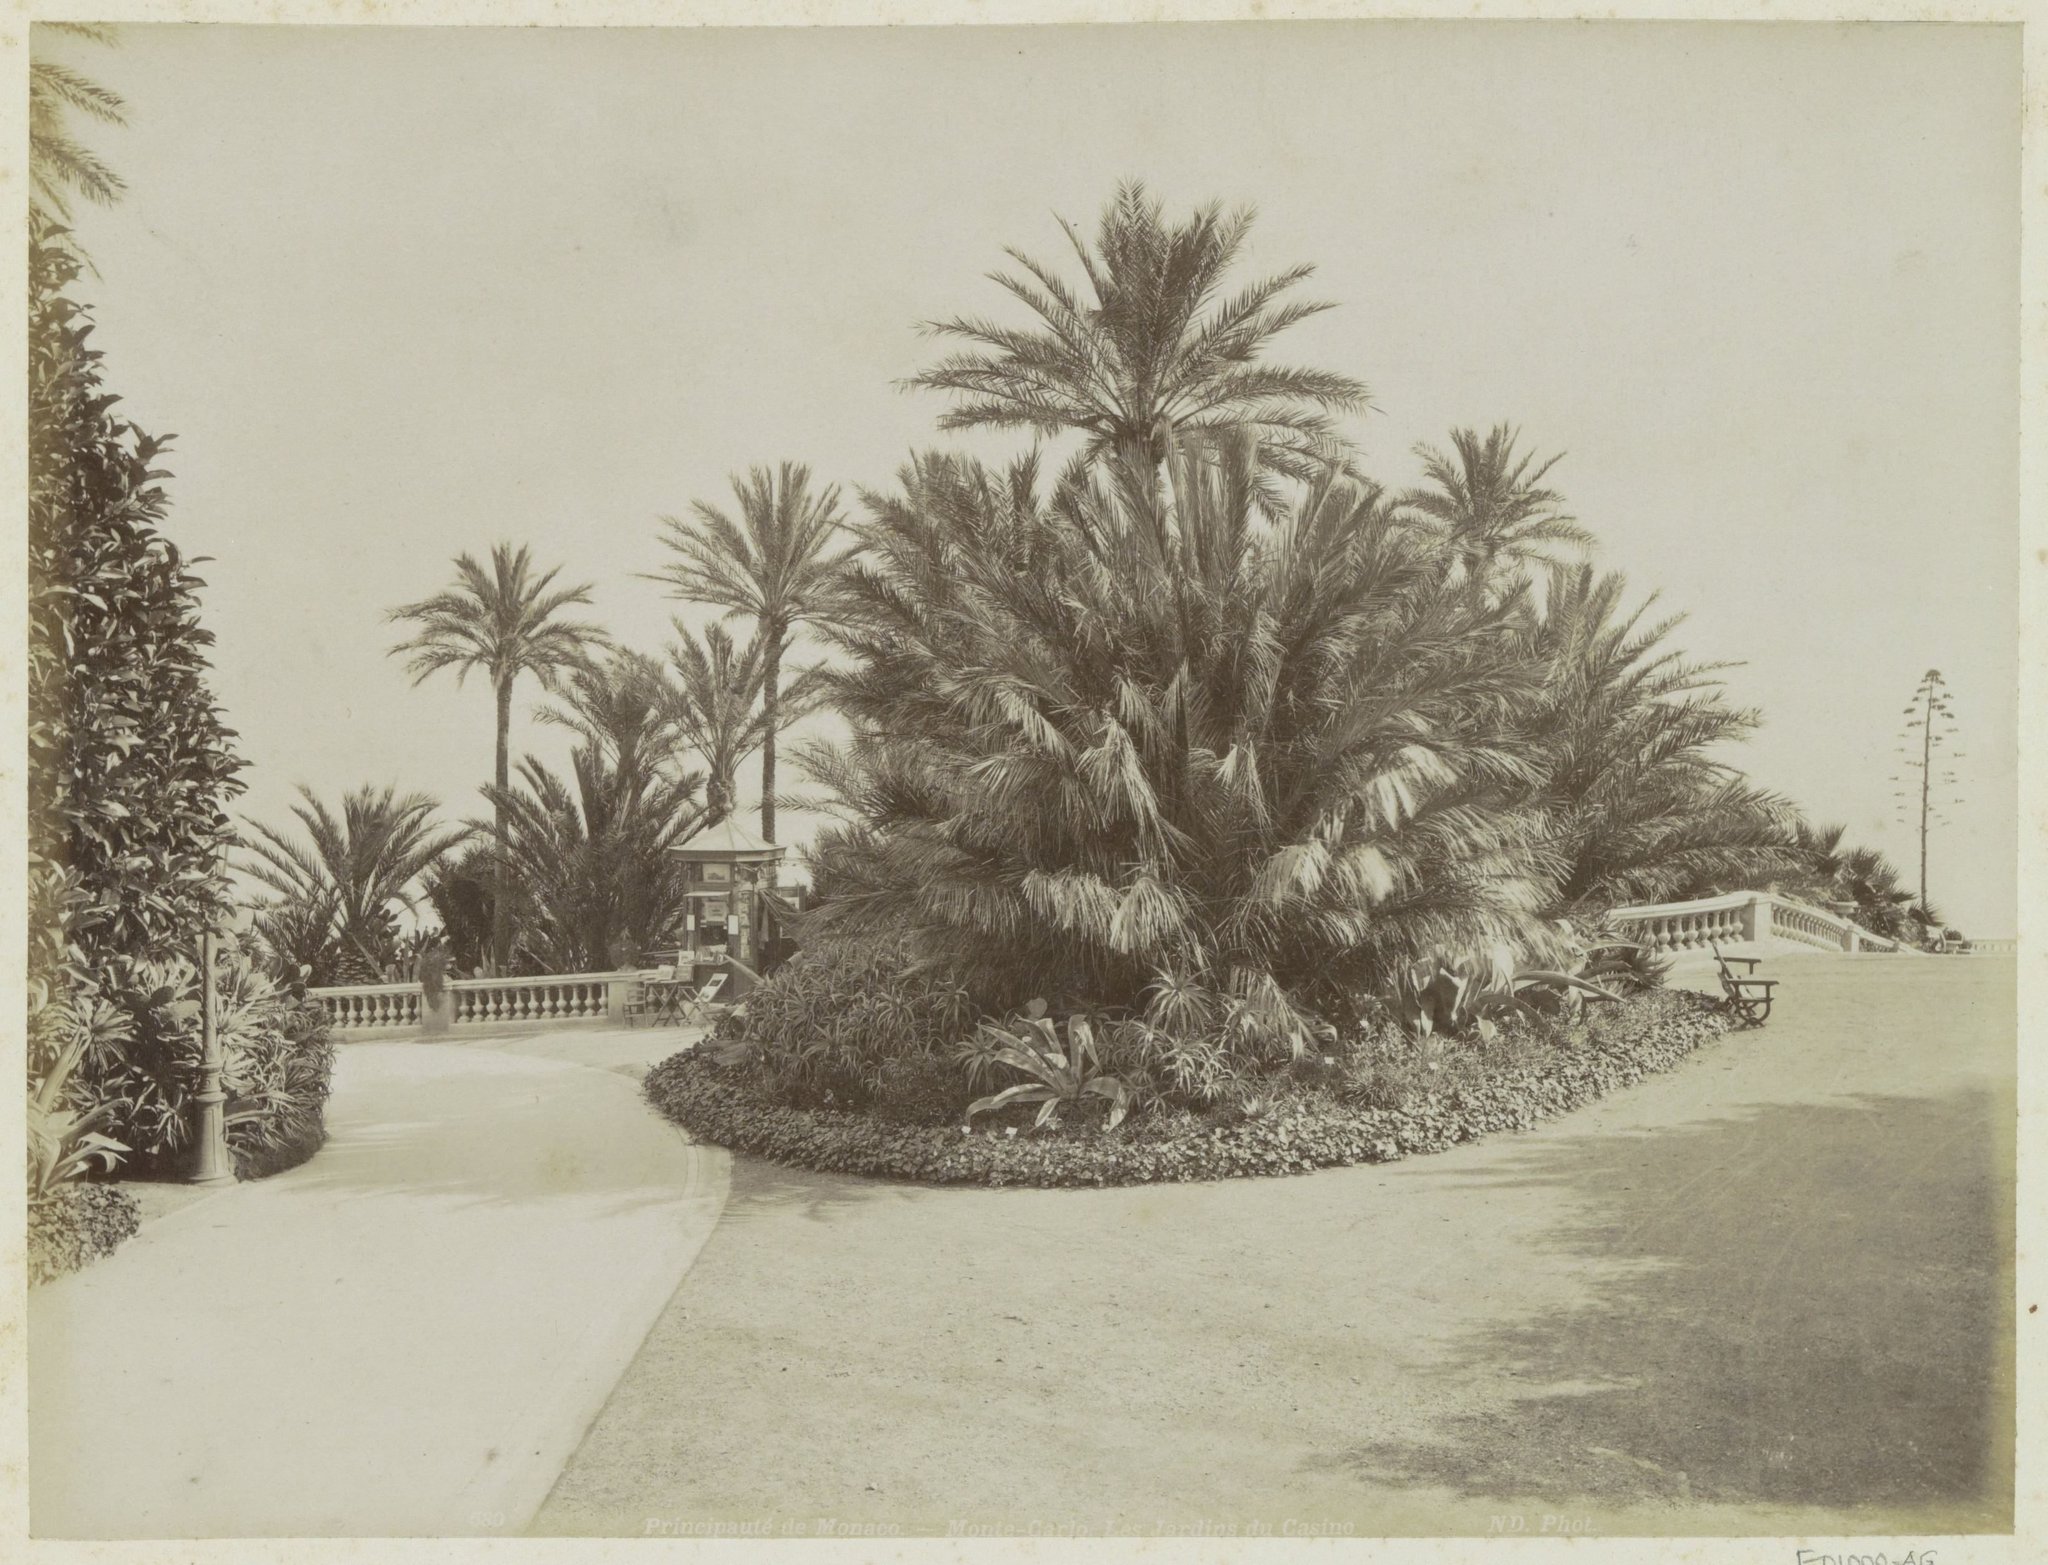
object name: photograph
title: Tuinen bij het Monte Carlo Casino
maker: étienne neurdein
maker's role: publisher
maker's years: 1832-1918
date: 1870-1900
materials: paper, photographic support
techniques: albumen print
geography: monaco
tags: casino, public gardens, park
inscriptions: negative number: ‘580’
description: Onderdeel van Reisalbum met foto's van bezienswaardigheden in Italië en Frankrijk.